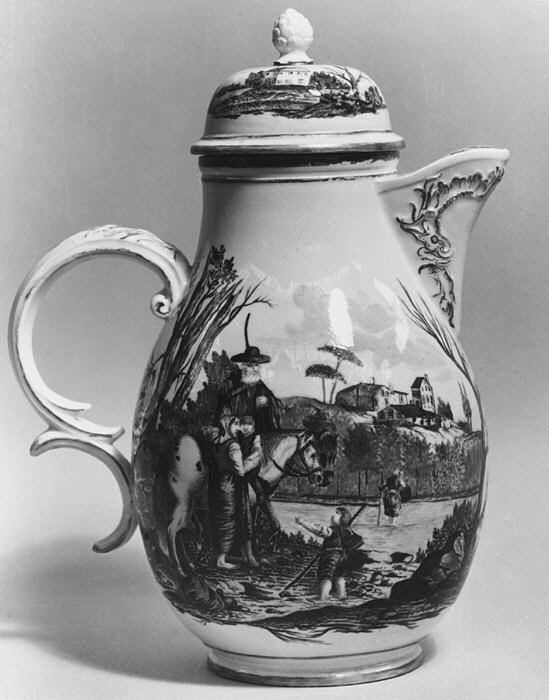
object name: coffeepot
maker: nymphenburg porcelain manufactory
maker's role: manufactory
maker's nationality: german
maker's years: 1747-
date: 1760-1770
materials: hard paste porcelain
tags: boys,men,women,horses